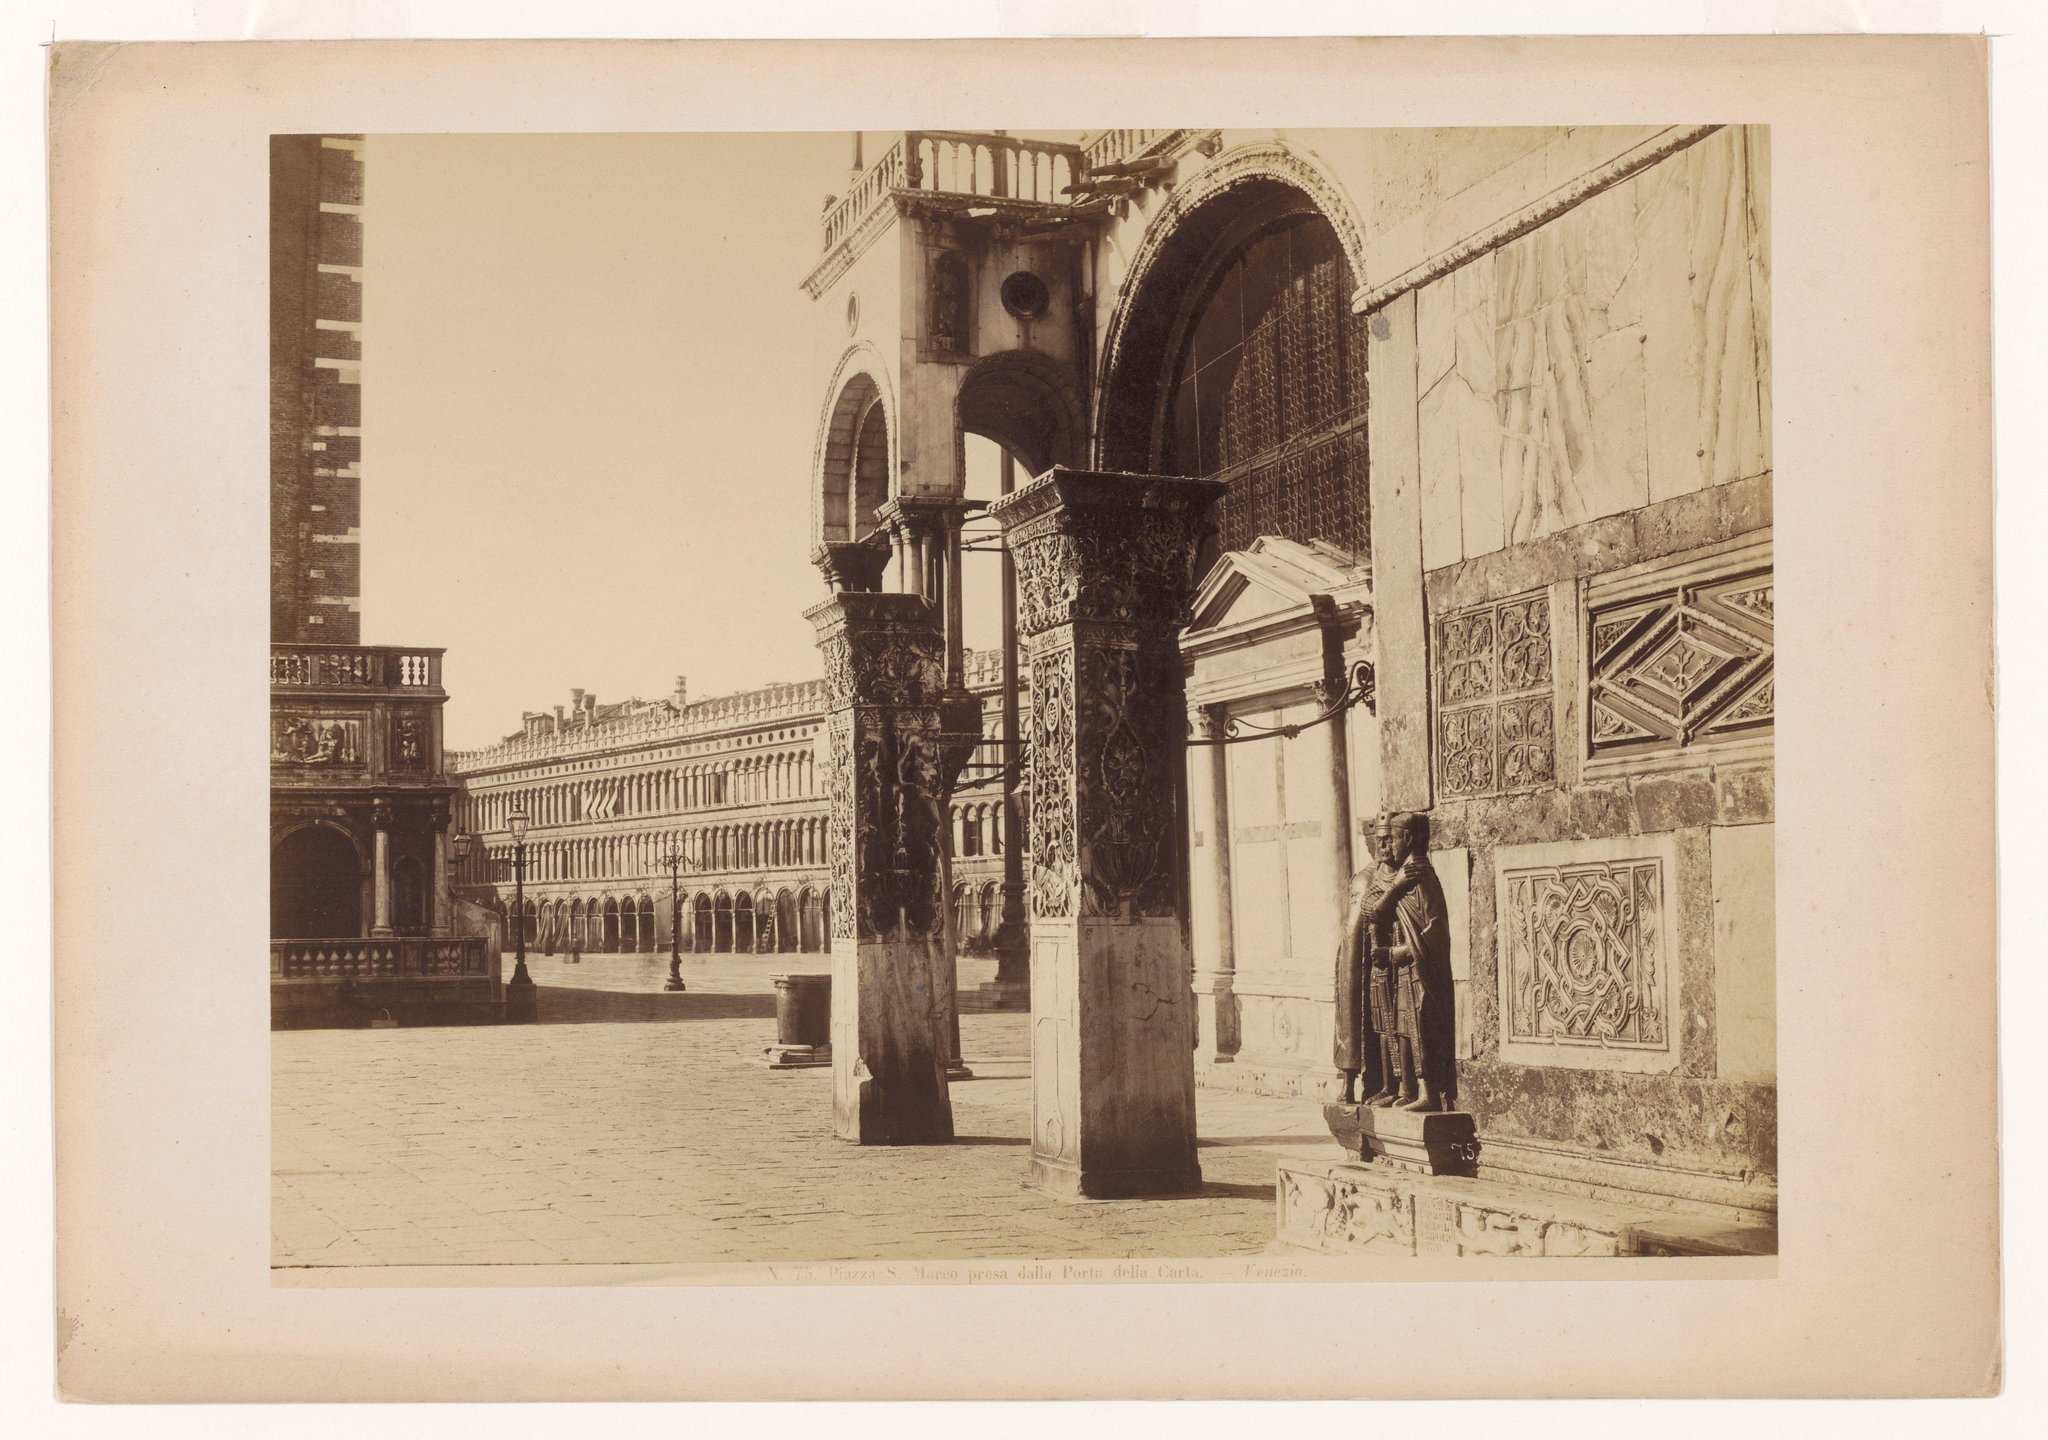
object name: photograph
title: Piazza S. Marco presa dalla Porta della Carta. Venezia.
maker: carlo naya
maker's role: fotograaf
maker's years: 1816-1882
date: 1875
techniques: albumen print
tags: venice